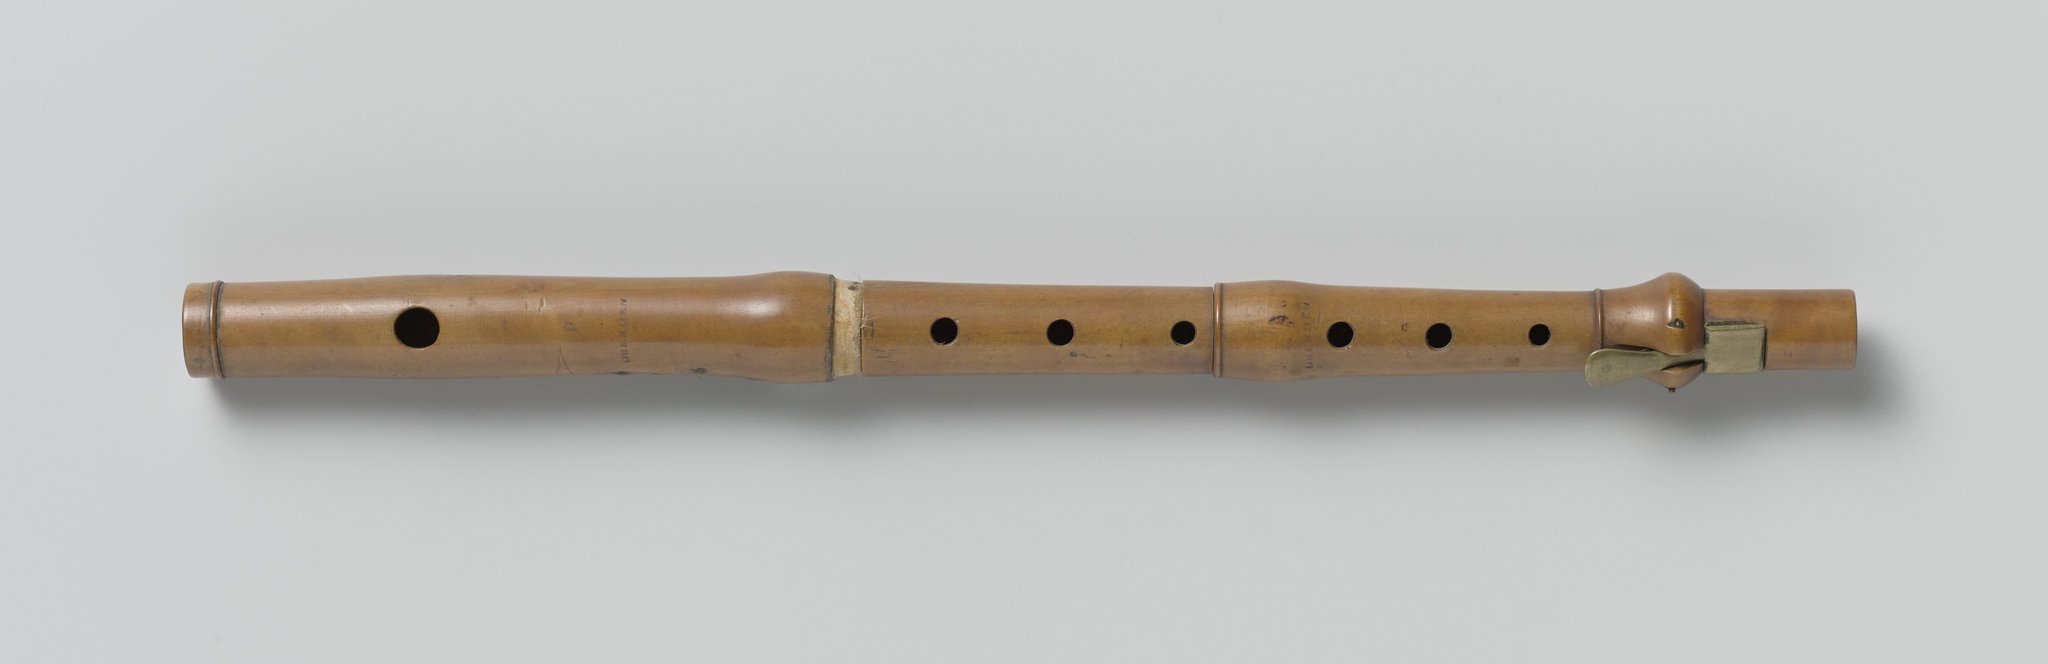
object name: wind instrument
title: Piccolo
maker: Anonymous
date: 1800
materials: wood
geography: dresden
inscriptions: stamp: ‘Dresden’, stamp: ‘[...]/ Dresden’